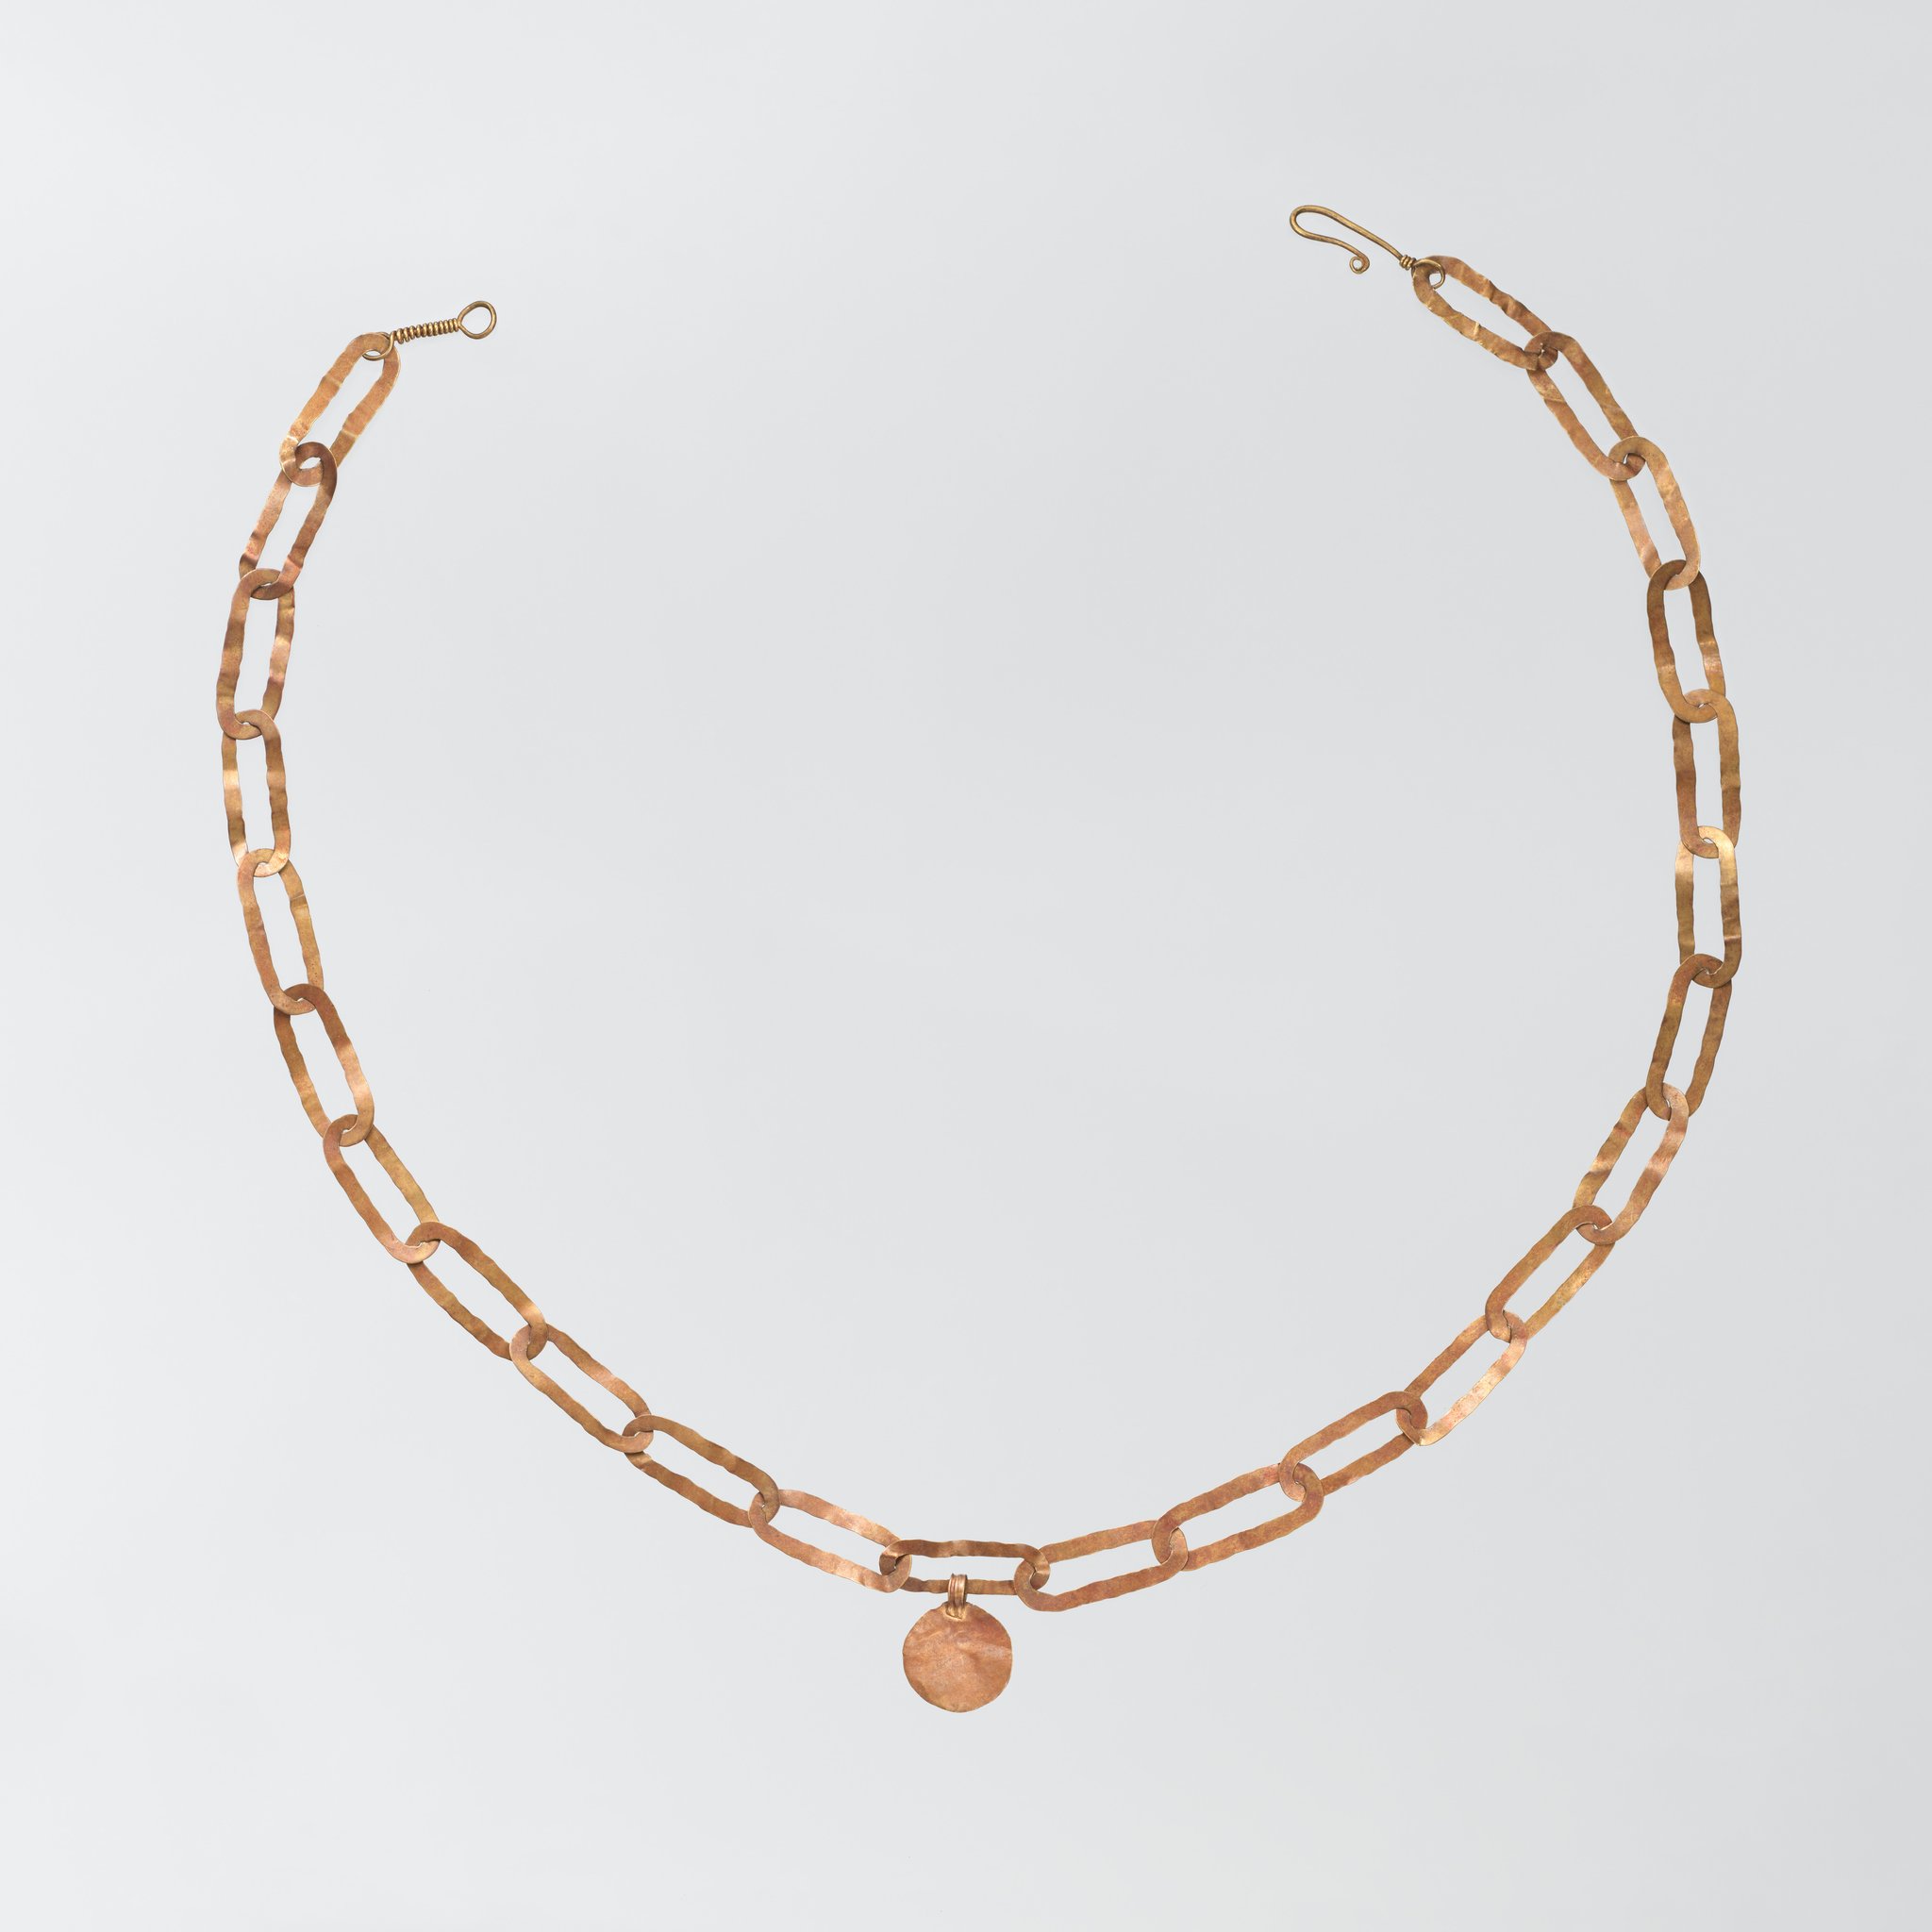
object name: necklace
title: Gold necklace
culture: roman, cypriot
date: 101-233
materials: gold